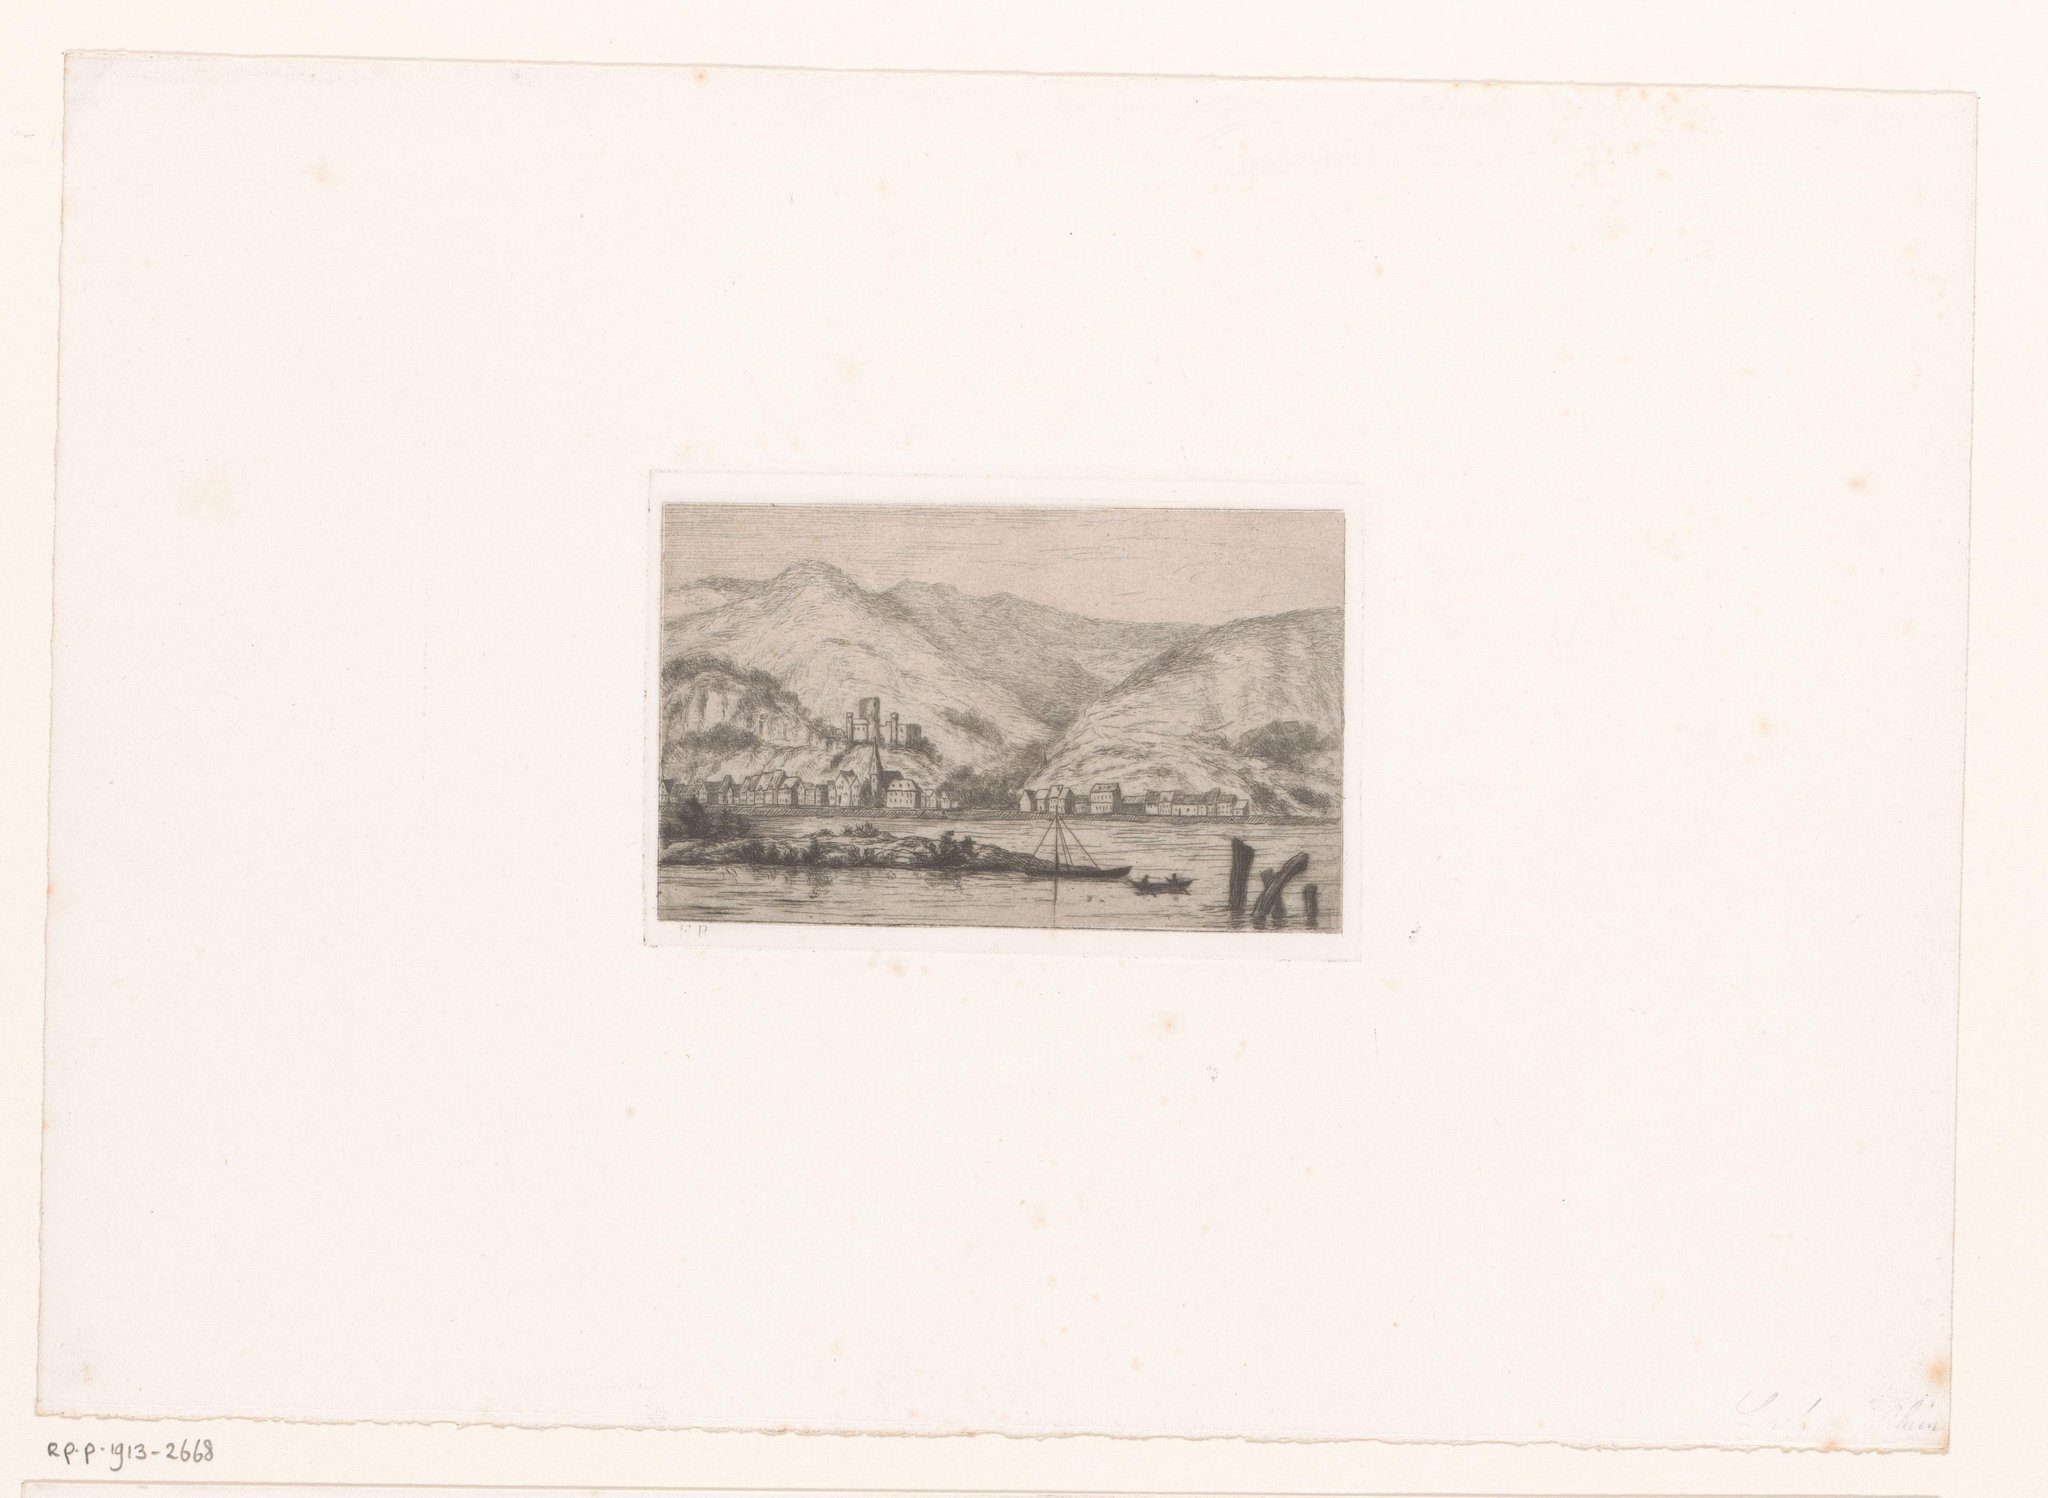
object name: print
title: Berglandschap met dorp aan het water nabij Lorch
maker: emilie rolin-jacquemijns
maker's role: print maker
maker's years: 1842-1906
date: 1852-1906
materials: paper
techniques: etching, retroussage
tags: prospect of village, silhouette of village, water course, mountains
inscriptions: collector's mark: Lugt 2228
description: Mogelijk is de burcht in de achtergrond Rheinstein of Reichenstein.